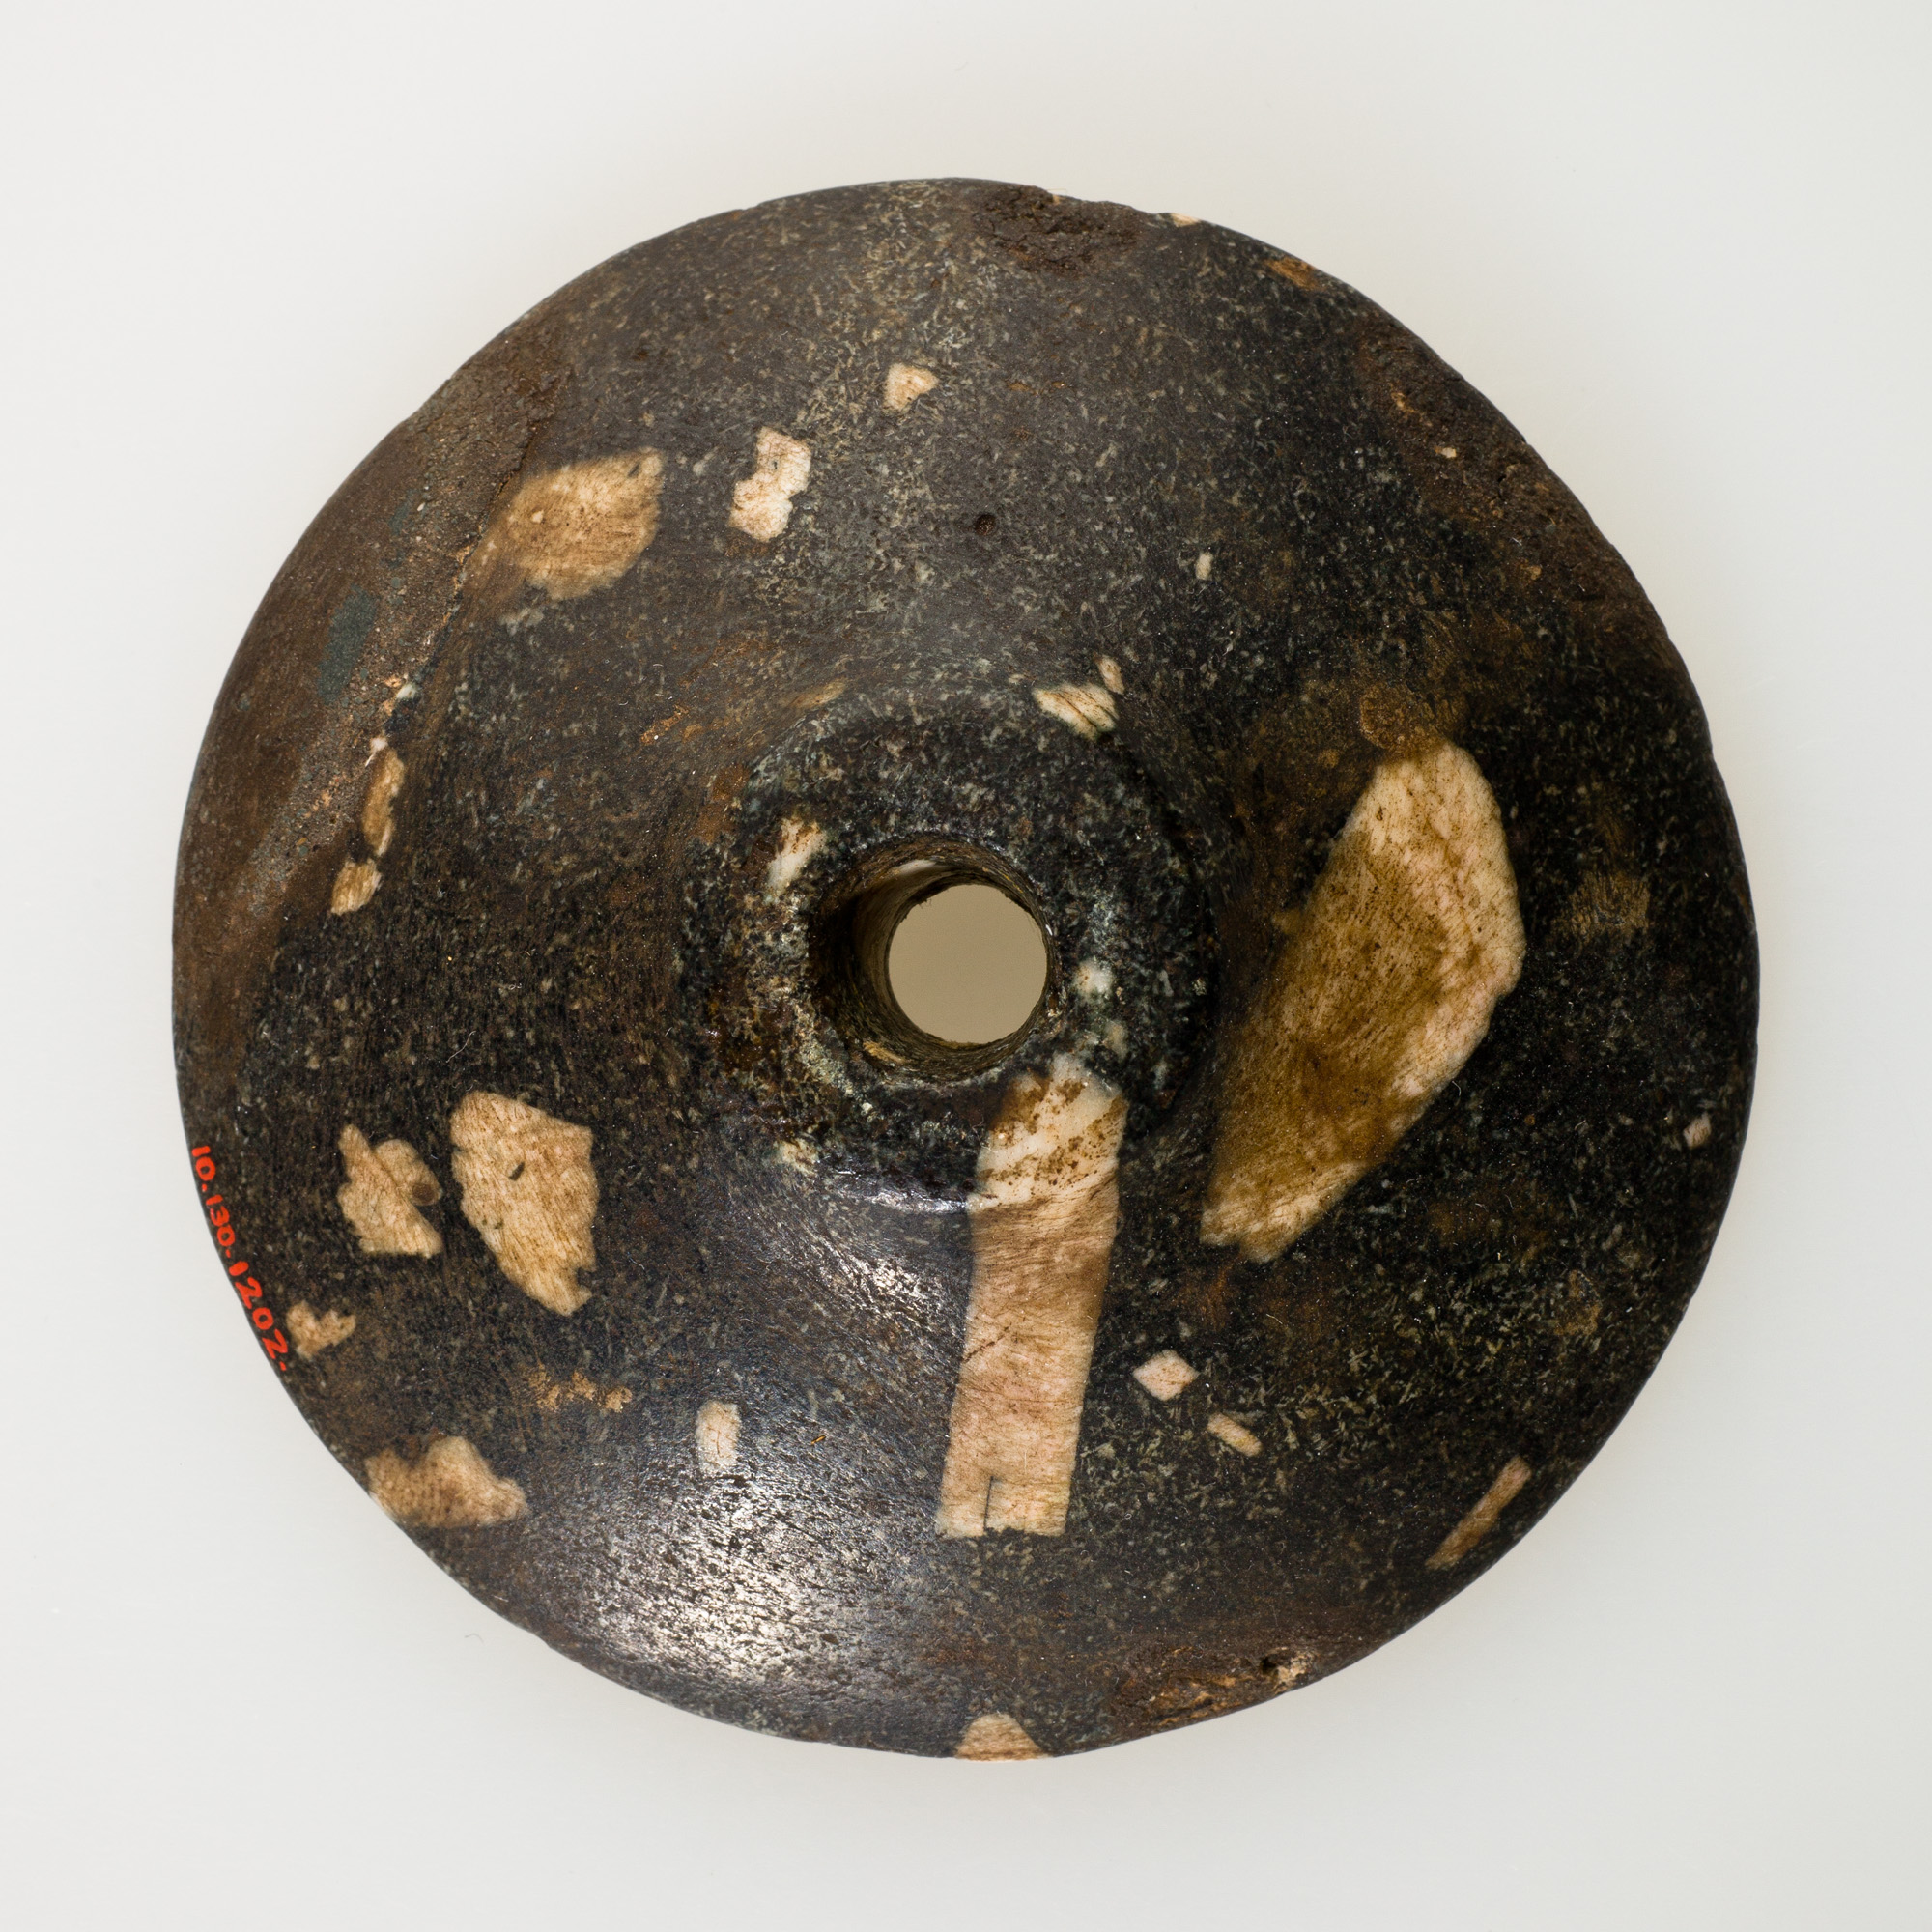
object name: mace head, disc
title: Disc-shaped mace head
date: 3850-2960 BCE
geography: egypt